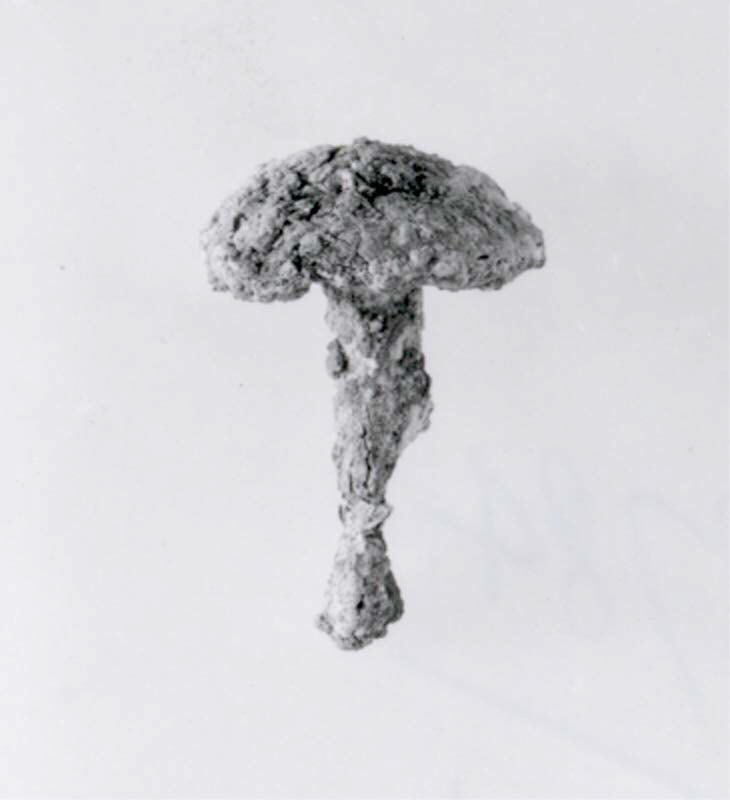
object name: nail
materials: bronze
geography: mesopotamia